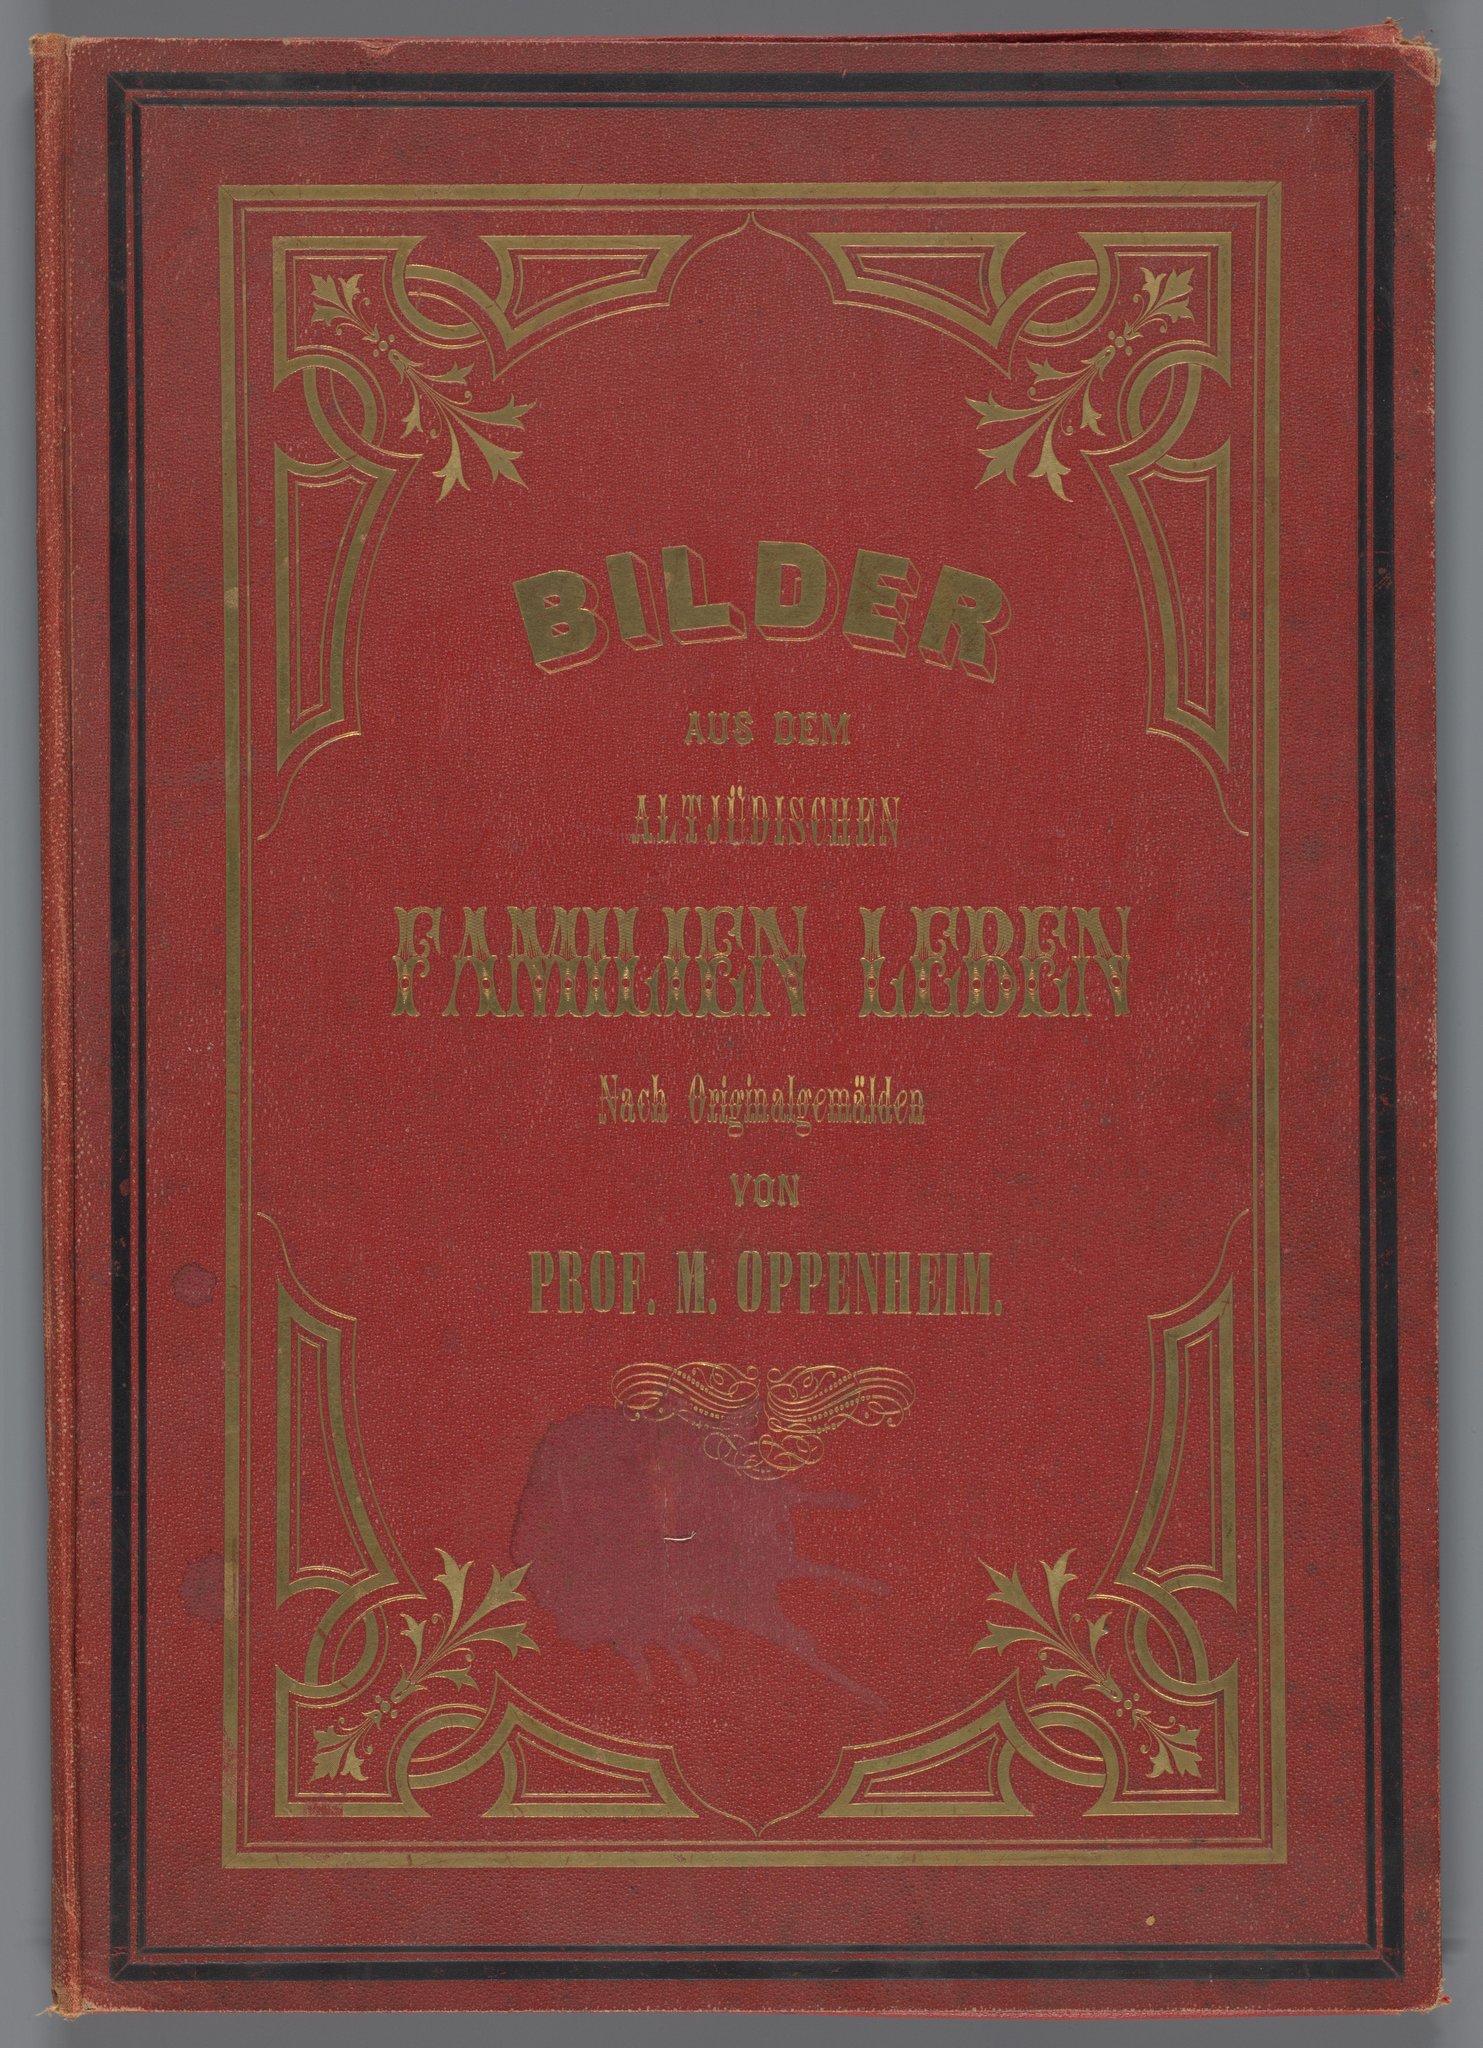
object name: folder container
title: Map met tien bladen met reproducties van schilderijen door Moritz Daniel Oppenheim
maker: heinrich keller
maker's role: draughtsman, publisher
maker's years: 1778-1862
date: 1866-1900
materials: cardboard, linen, paper, photographic support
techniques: printing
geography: frankfurt am main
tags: picture, painting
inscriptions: collector's mark: ‘DIENST/ VERSPREIDE/ RIJKSKOLLEKTIES/ (...) F01068’, retailer's mark: ‘M. STETTENHEIM/ HAMBURG’, annotation: ‘uiterst zeldz. compl. set/ met tekst/ zie [..]d. Lex IV p. 586/ Bene[.]it VII, 433/ Nagler XI, 478’, retailer's mark: ‘"PAMPIERE WERELD"/ SALOMON S. MEYER/ Antiquariaat-Graphiek/ Hebraica-Judaica/ Keizersgracht 428-432/ Amsterdam-C./ Telefoon 252069-715782’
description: Map met zes bladen met daarop zes foto's en een tekstblad. Afgebeeld zijn zes fotoreproducties van schilderijen van het Joodse familieleven door Moritz Daniel Oppenheim.